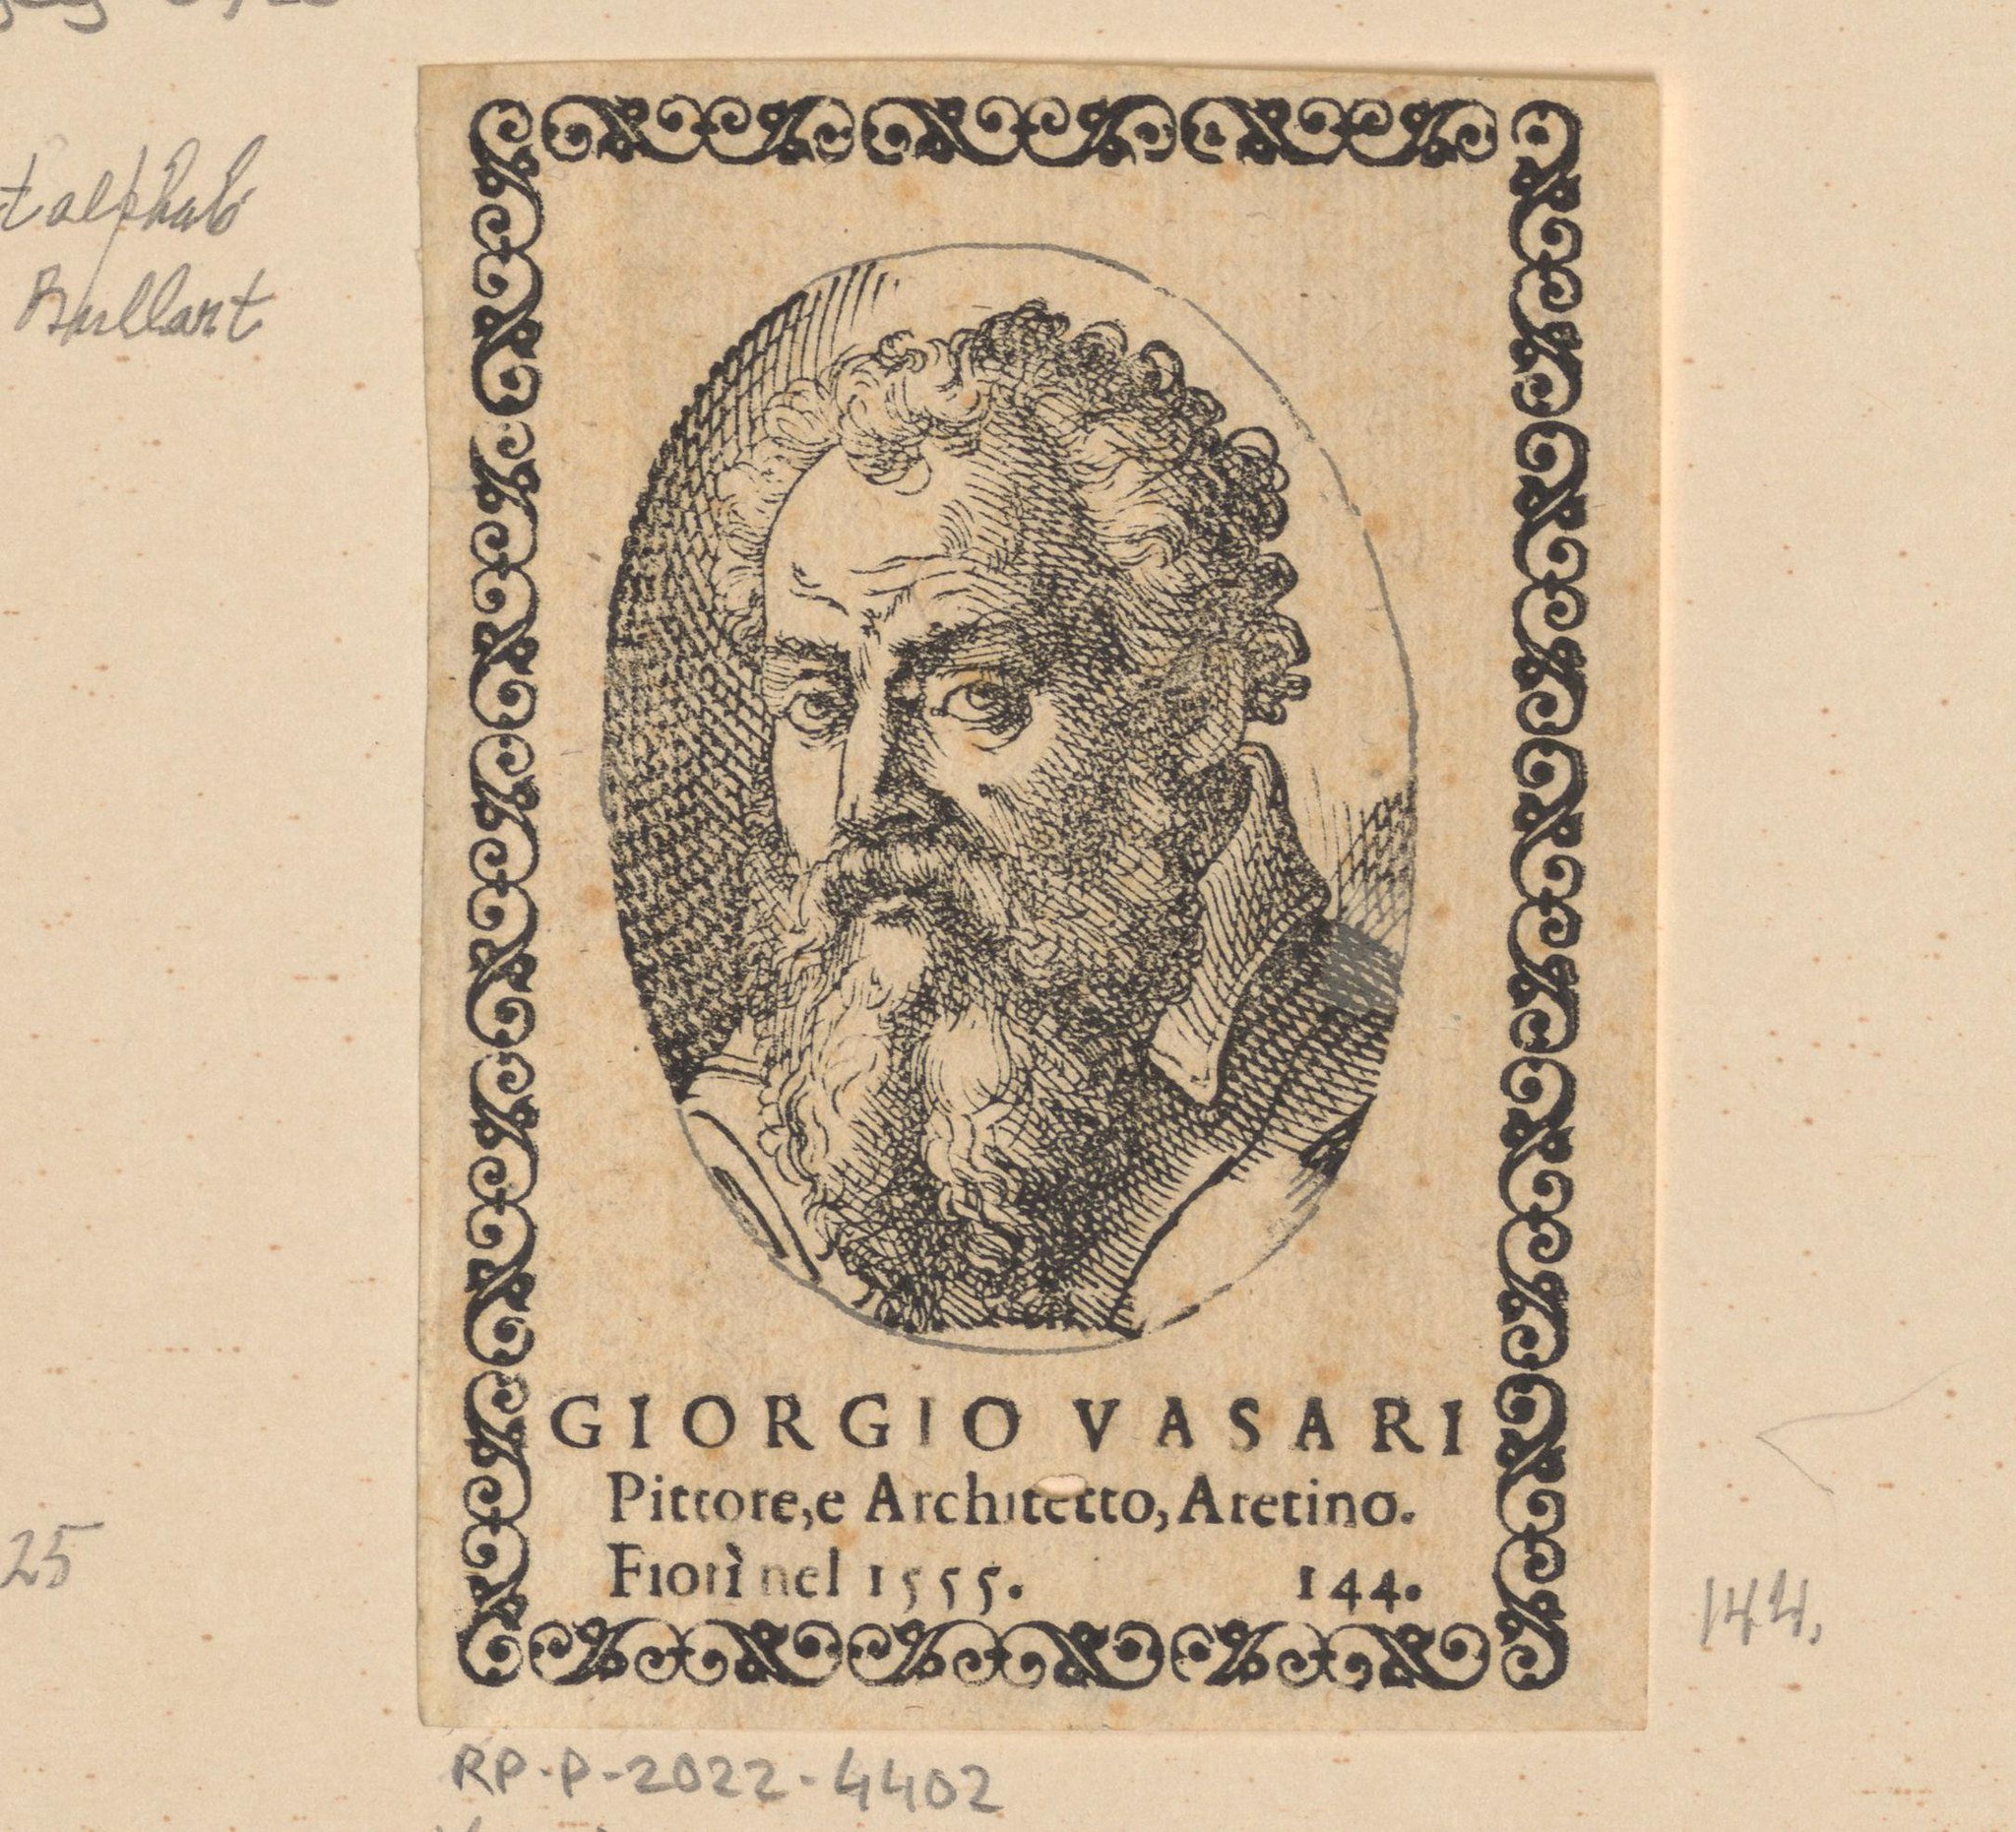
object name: print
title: Portret van Giorgio Vasari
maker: cristoforo coriolano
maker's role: print maker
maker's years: 1540-1610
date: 1568-1650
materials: ink, paper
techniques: letterpress printing, pen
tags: painter, draughtsman, giorgio vasari, historical persons, portrait of a writer, portrait, self-portrait of painter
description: Prent komt uit een editie van Vasari's 'Vite'. Prent met een andere omlijsting is gebruikt in de editie uit 1568: Vasari, Giorgio. Le vite de' piu eccellenti pittori scultori, e architettori. Florence: Filippo Giunta, 1568. En mogelijk in de editie uit 1647.